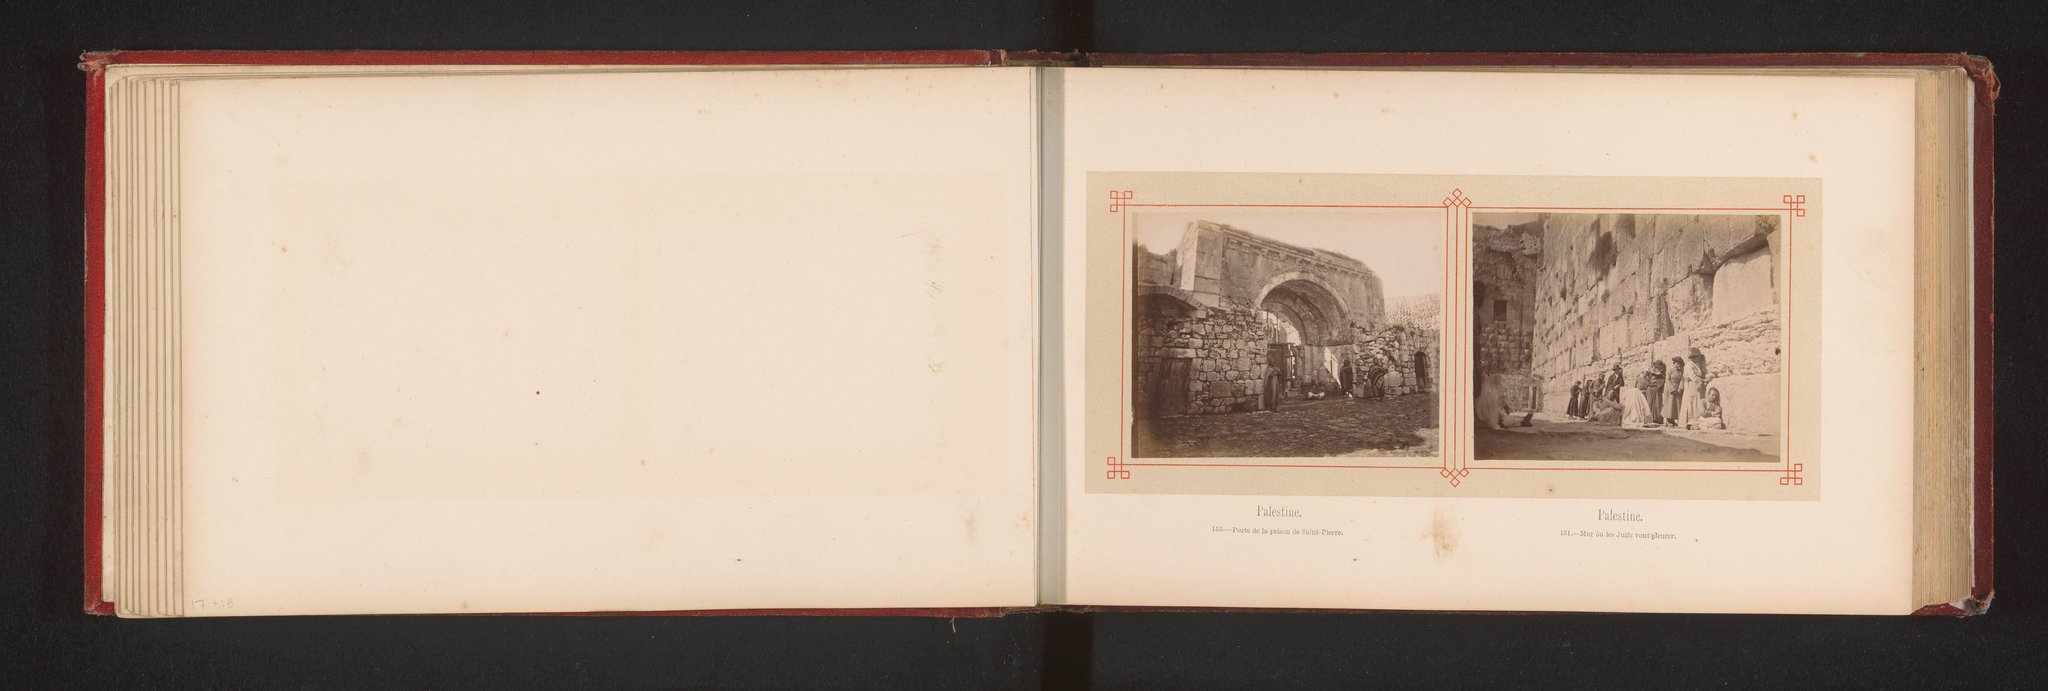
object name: photograph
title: Palestine - 155. Porte de la prison de Saint-Pierre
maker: félix bonfils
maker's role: fotograaf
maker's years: 1831-1885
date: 1873-1878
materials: photographic support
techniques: albumen print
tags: gate, entrance